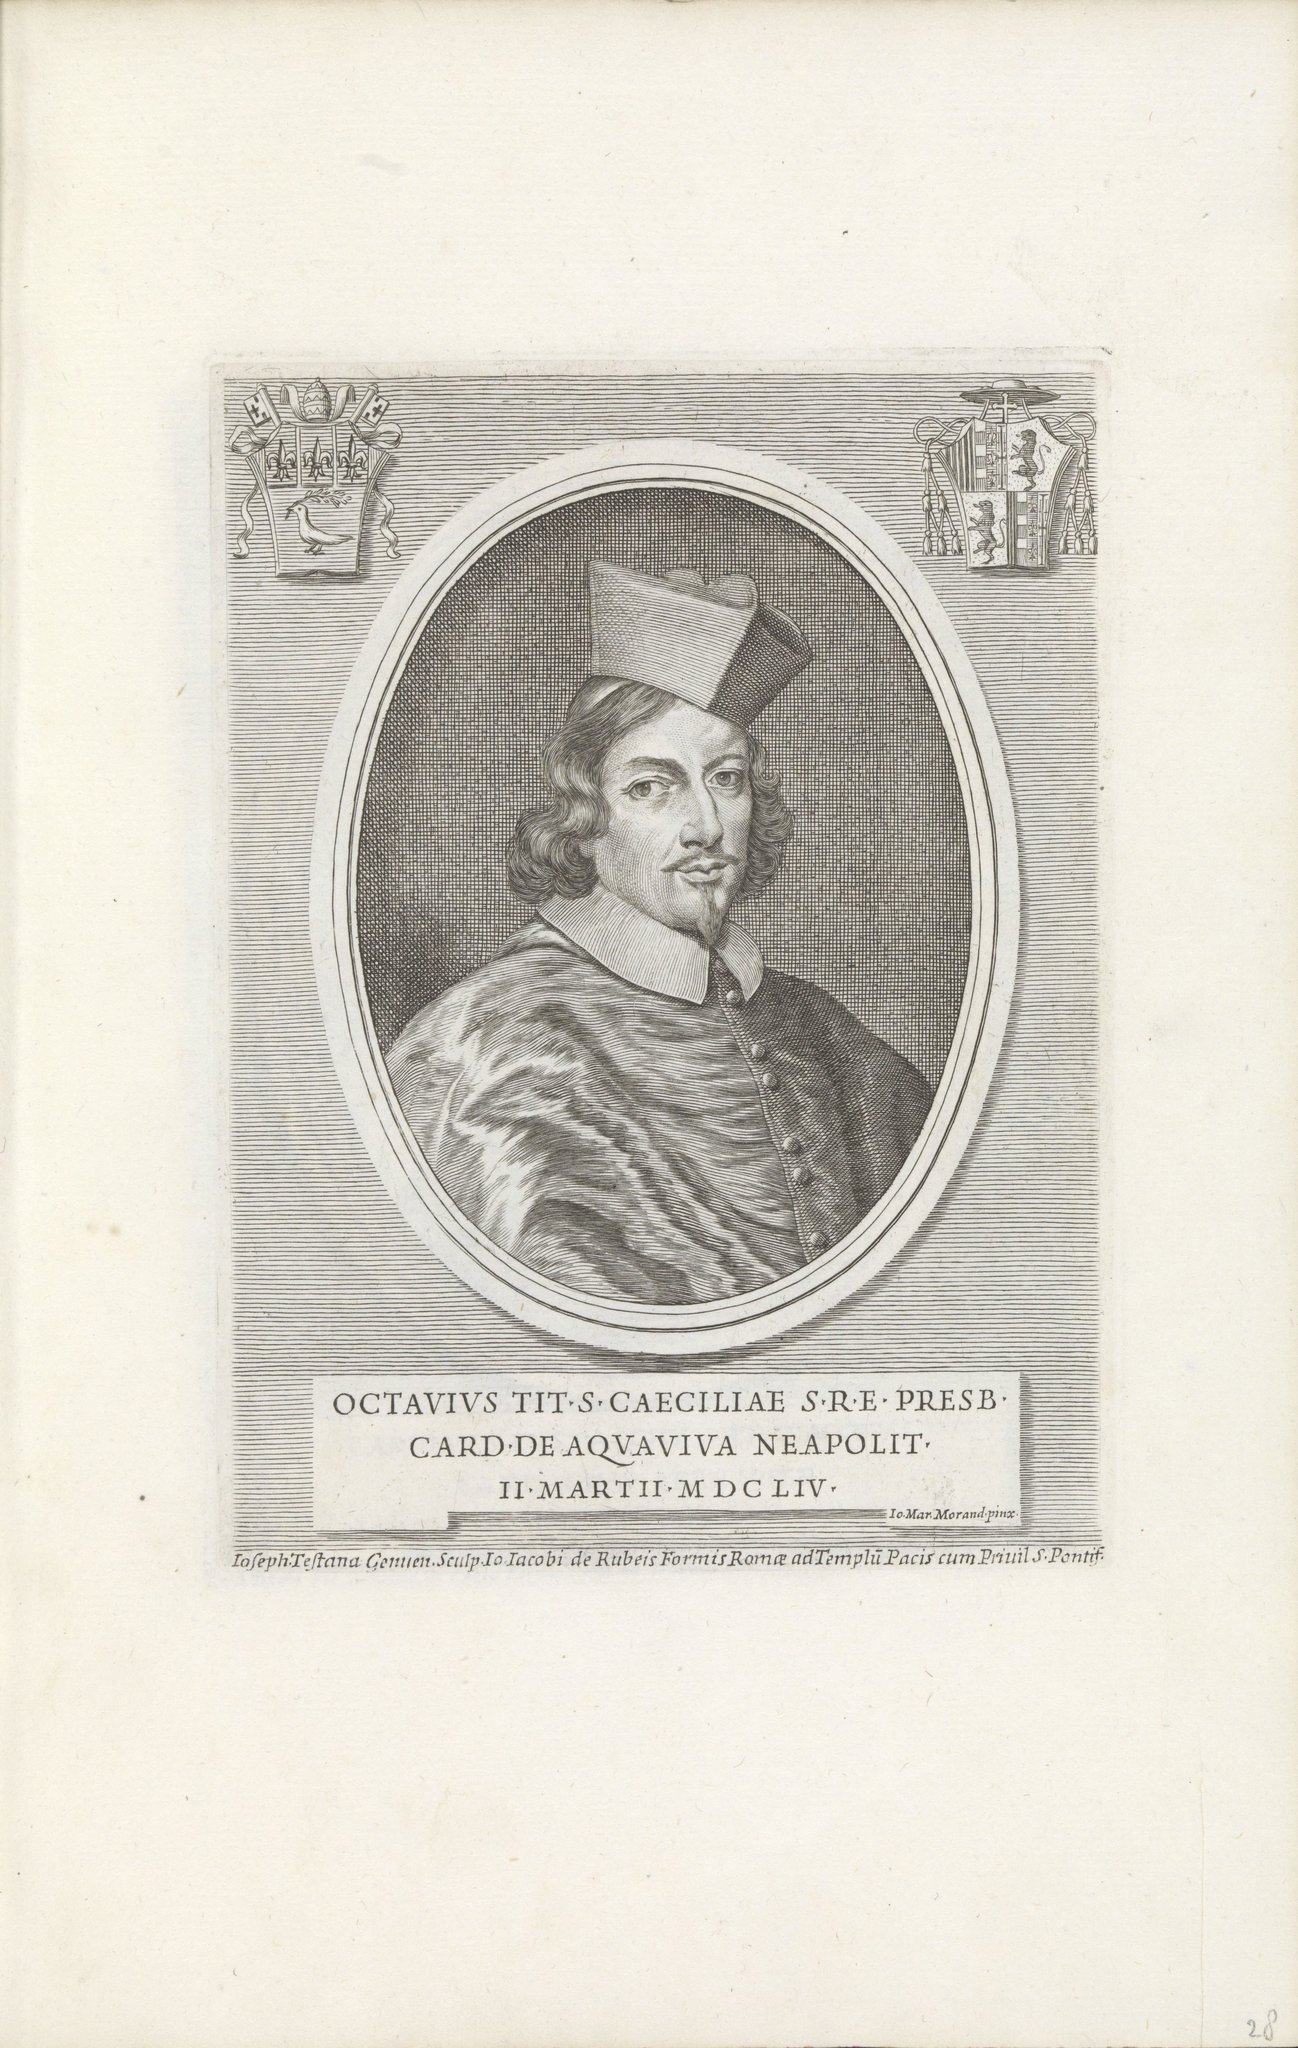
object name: print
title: Portret van kardinaal Ottavio Acquaviva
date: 1658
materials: paper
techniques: engraving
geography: rome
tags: naples, cardinal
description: Portret van kardinaal Ottavio Acquaviva. Linksboven het wapen van paus Innocentius X en rechtsboven het wapen van Acquaviva. Onderaan een onderschrift in het Latijn. De prent maakt deel uit van een album.